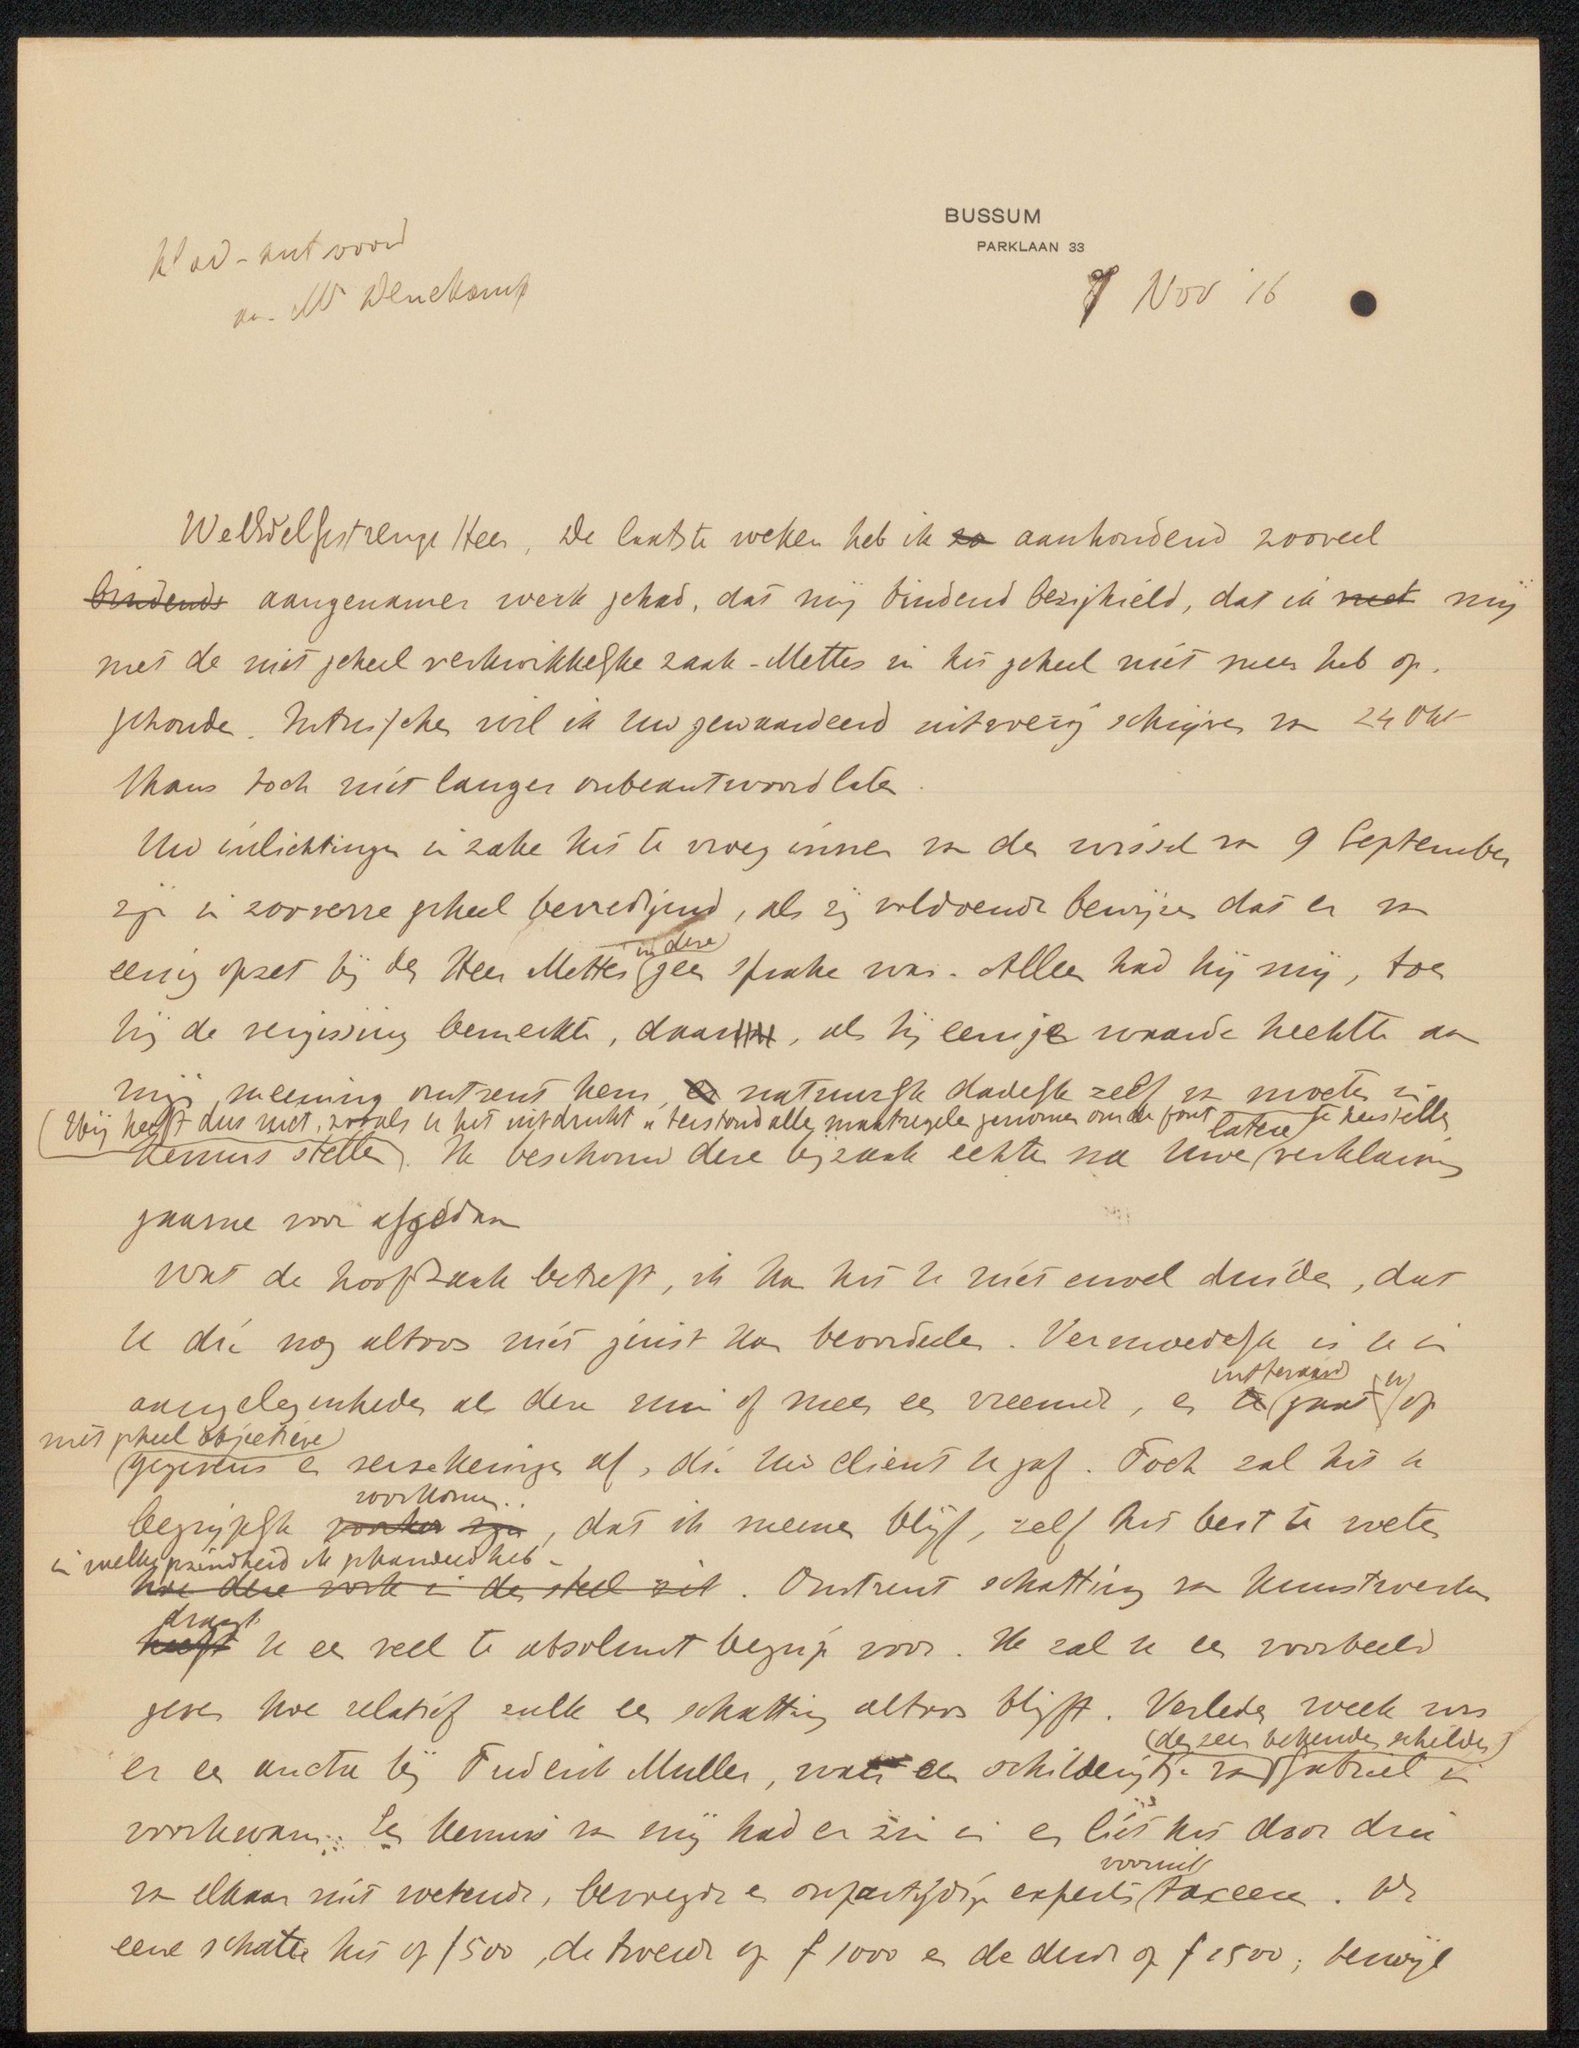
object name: letter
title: Brief aan L.P. Denekamp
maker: jan veth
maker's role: designer, draughtsman, painter, print maker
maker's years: 1864-1925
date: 1916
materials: ink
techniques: pen, writing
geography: bussum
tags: leiden, amsterdam, painter, print maker, draughtsman, rembrandt van rijn, l.p. denekamp, hoorn (north holland), the hague, art trade, art shop, the graphic arts, art collecting, money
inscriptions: collector's mark: ‘RPK’